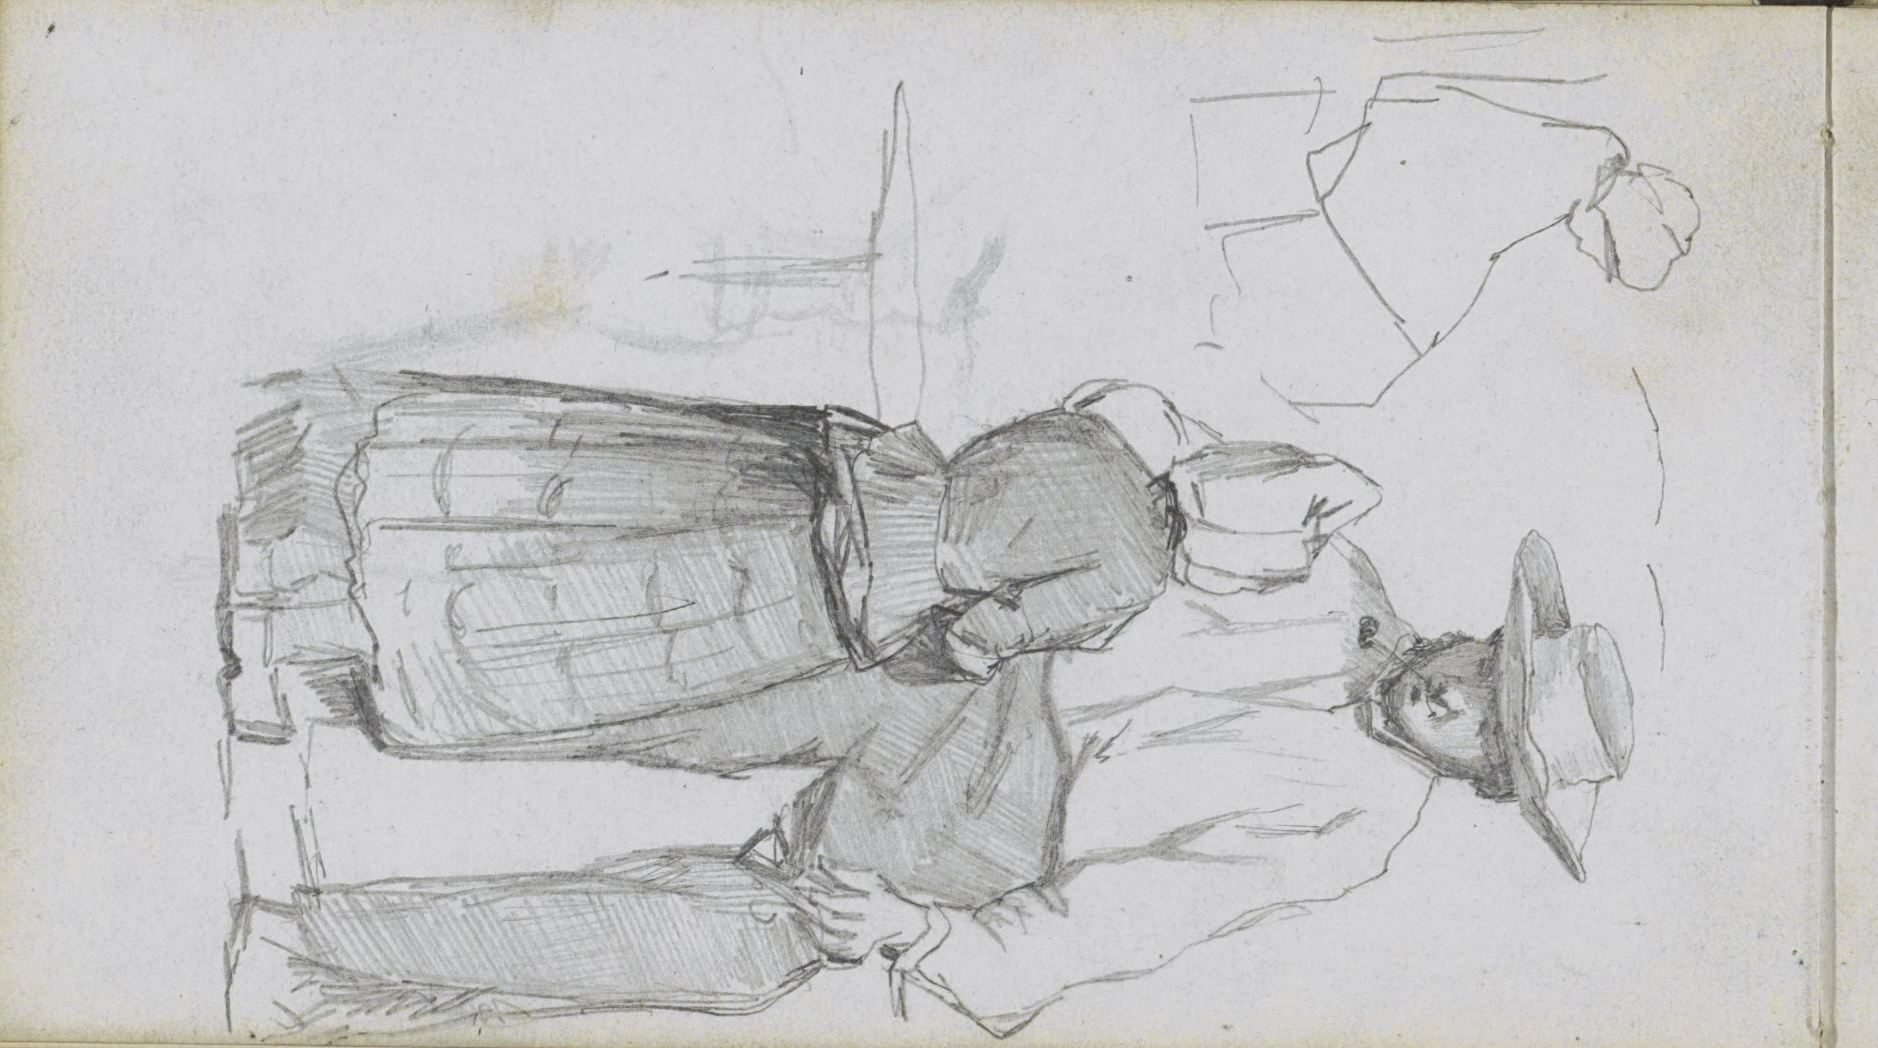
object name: sketchbook leaf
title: Zittende vrouw, man met een pijp en een vrouw op klompen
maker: johan hendrik weissenbruch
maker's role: draughtsman, painter, print maker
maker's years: 1824-1903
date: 1834-1903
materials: paper, pencil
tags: sitting figure (+ female (human being) (not to be used where -aa- is prescribed)), pipe ~ tobacco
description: Blad 23 verso uit een schetsboek met 39 bladen.